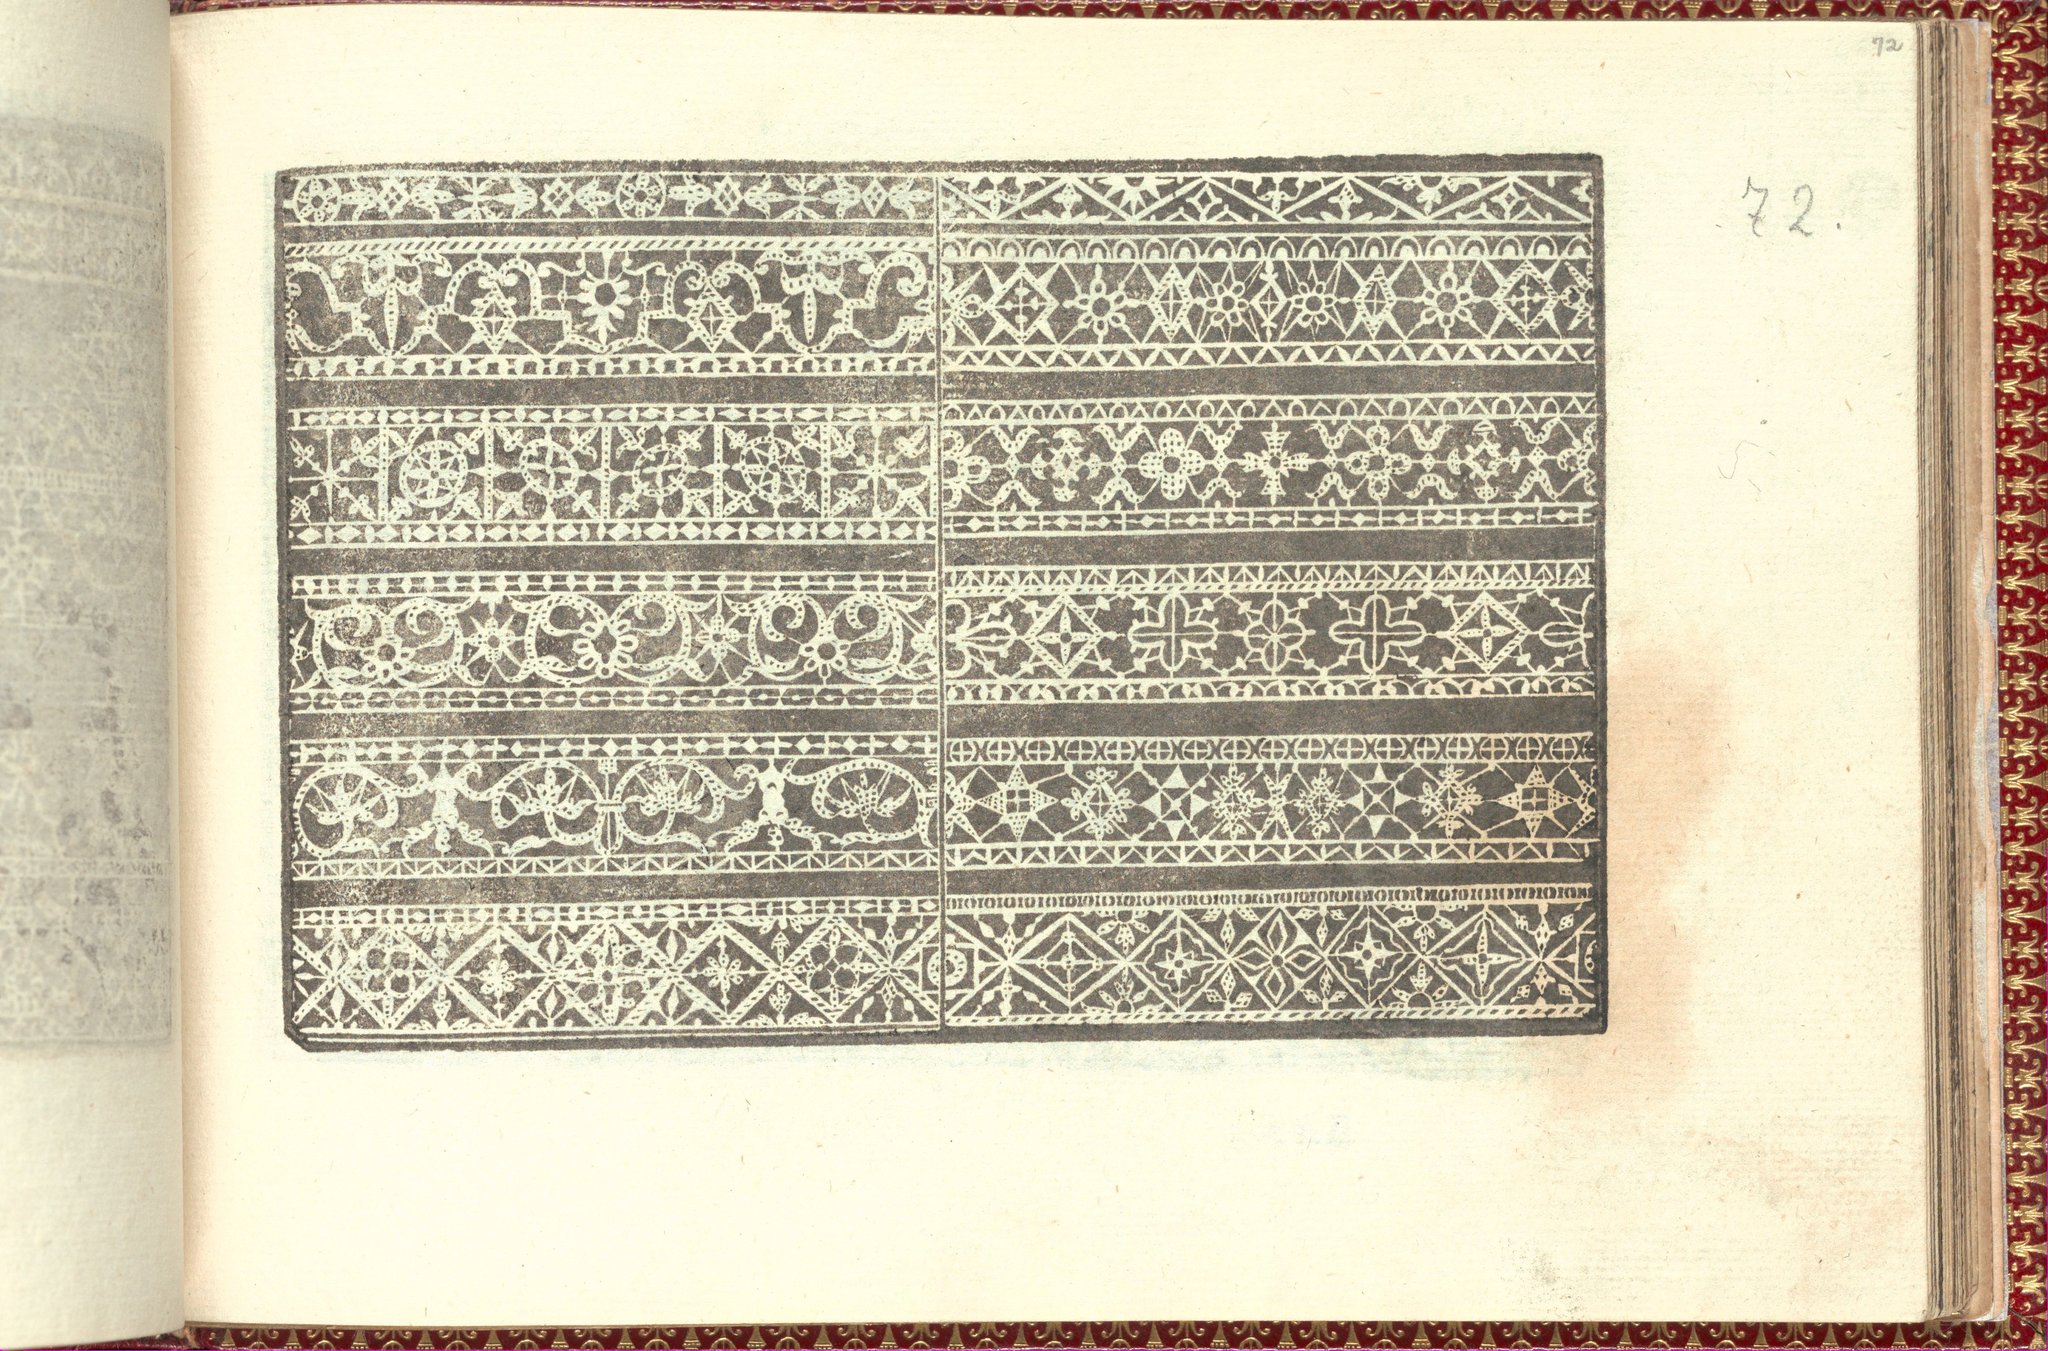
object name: book print ornament architecture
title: Corona delle Nobili et Virtuose Donne: Libro I-IV, page 72 (recto)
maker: cesare vecellio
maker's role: publisher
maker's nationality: italian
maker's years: 1521-1601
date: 1601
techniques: woodcut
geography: italy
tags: ornament